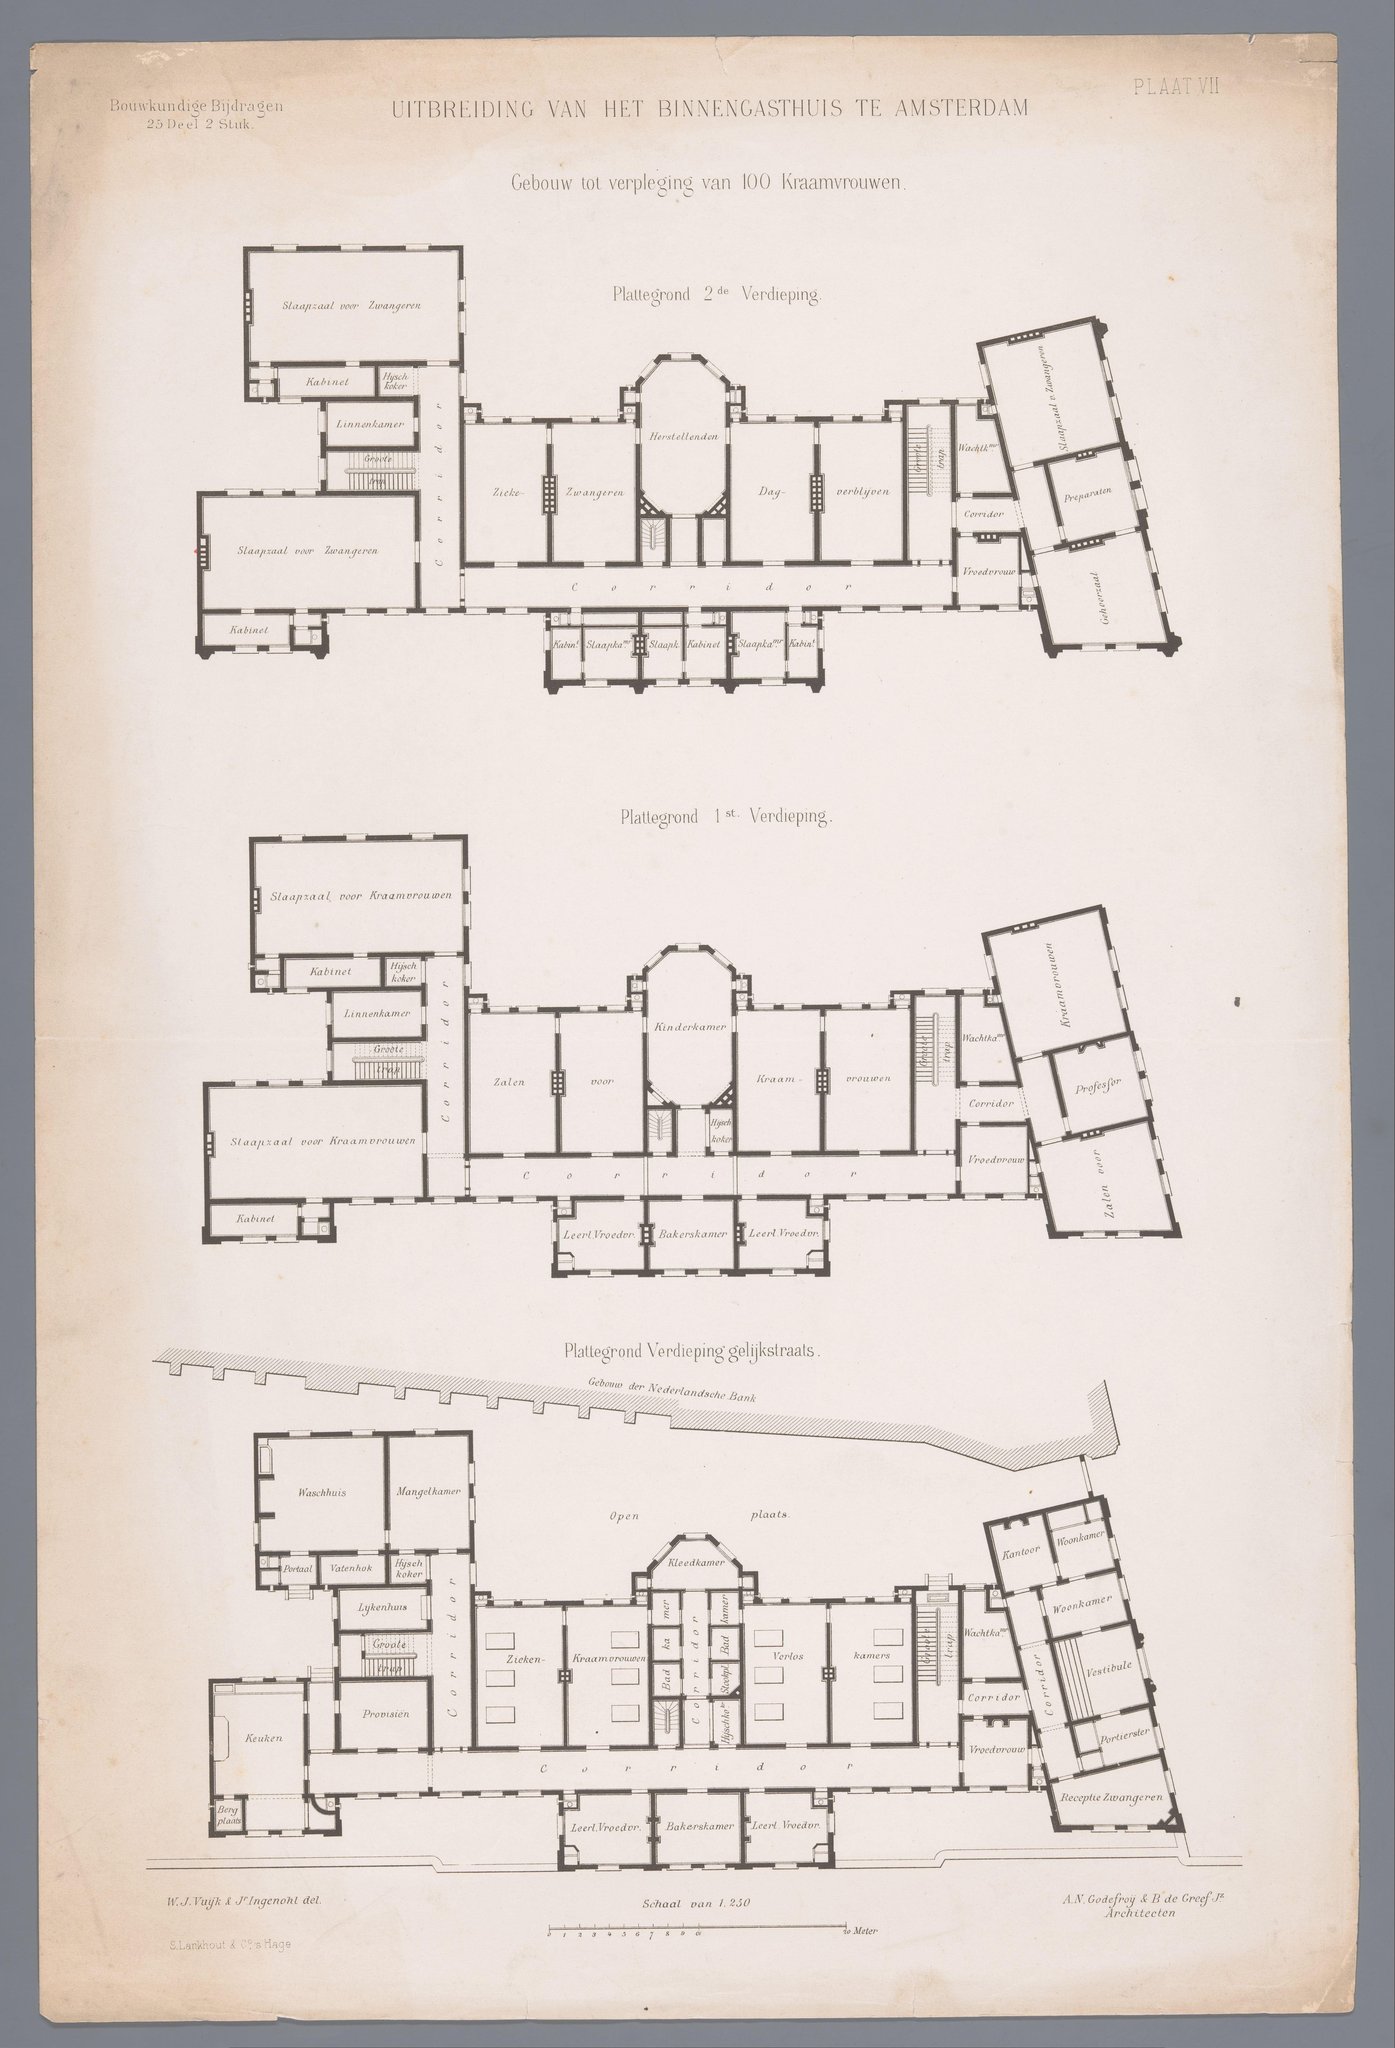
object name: print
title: Uitbreiding van het Binnengasthuis te Amsterdam. Gebouw tot verpleging van 100 kraamvrouwen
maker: Anonymous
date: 1879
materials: paper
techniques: lithograph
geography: amsterdam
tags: edifice, e.g.: public building, department store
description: Prent uit: Bouwkundige Bijdragen 25 (1879).